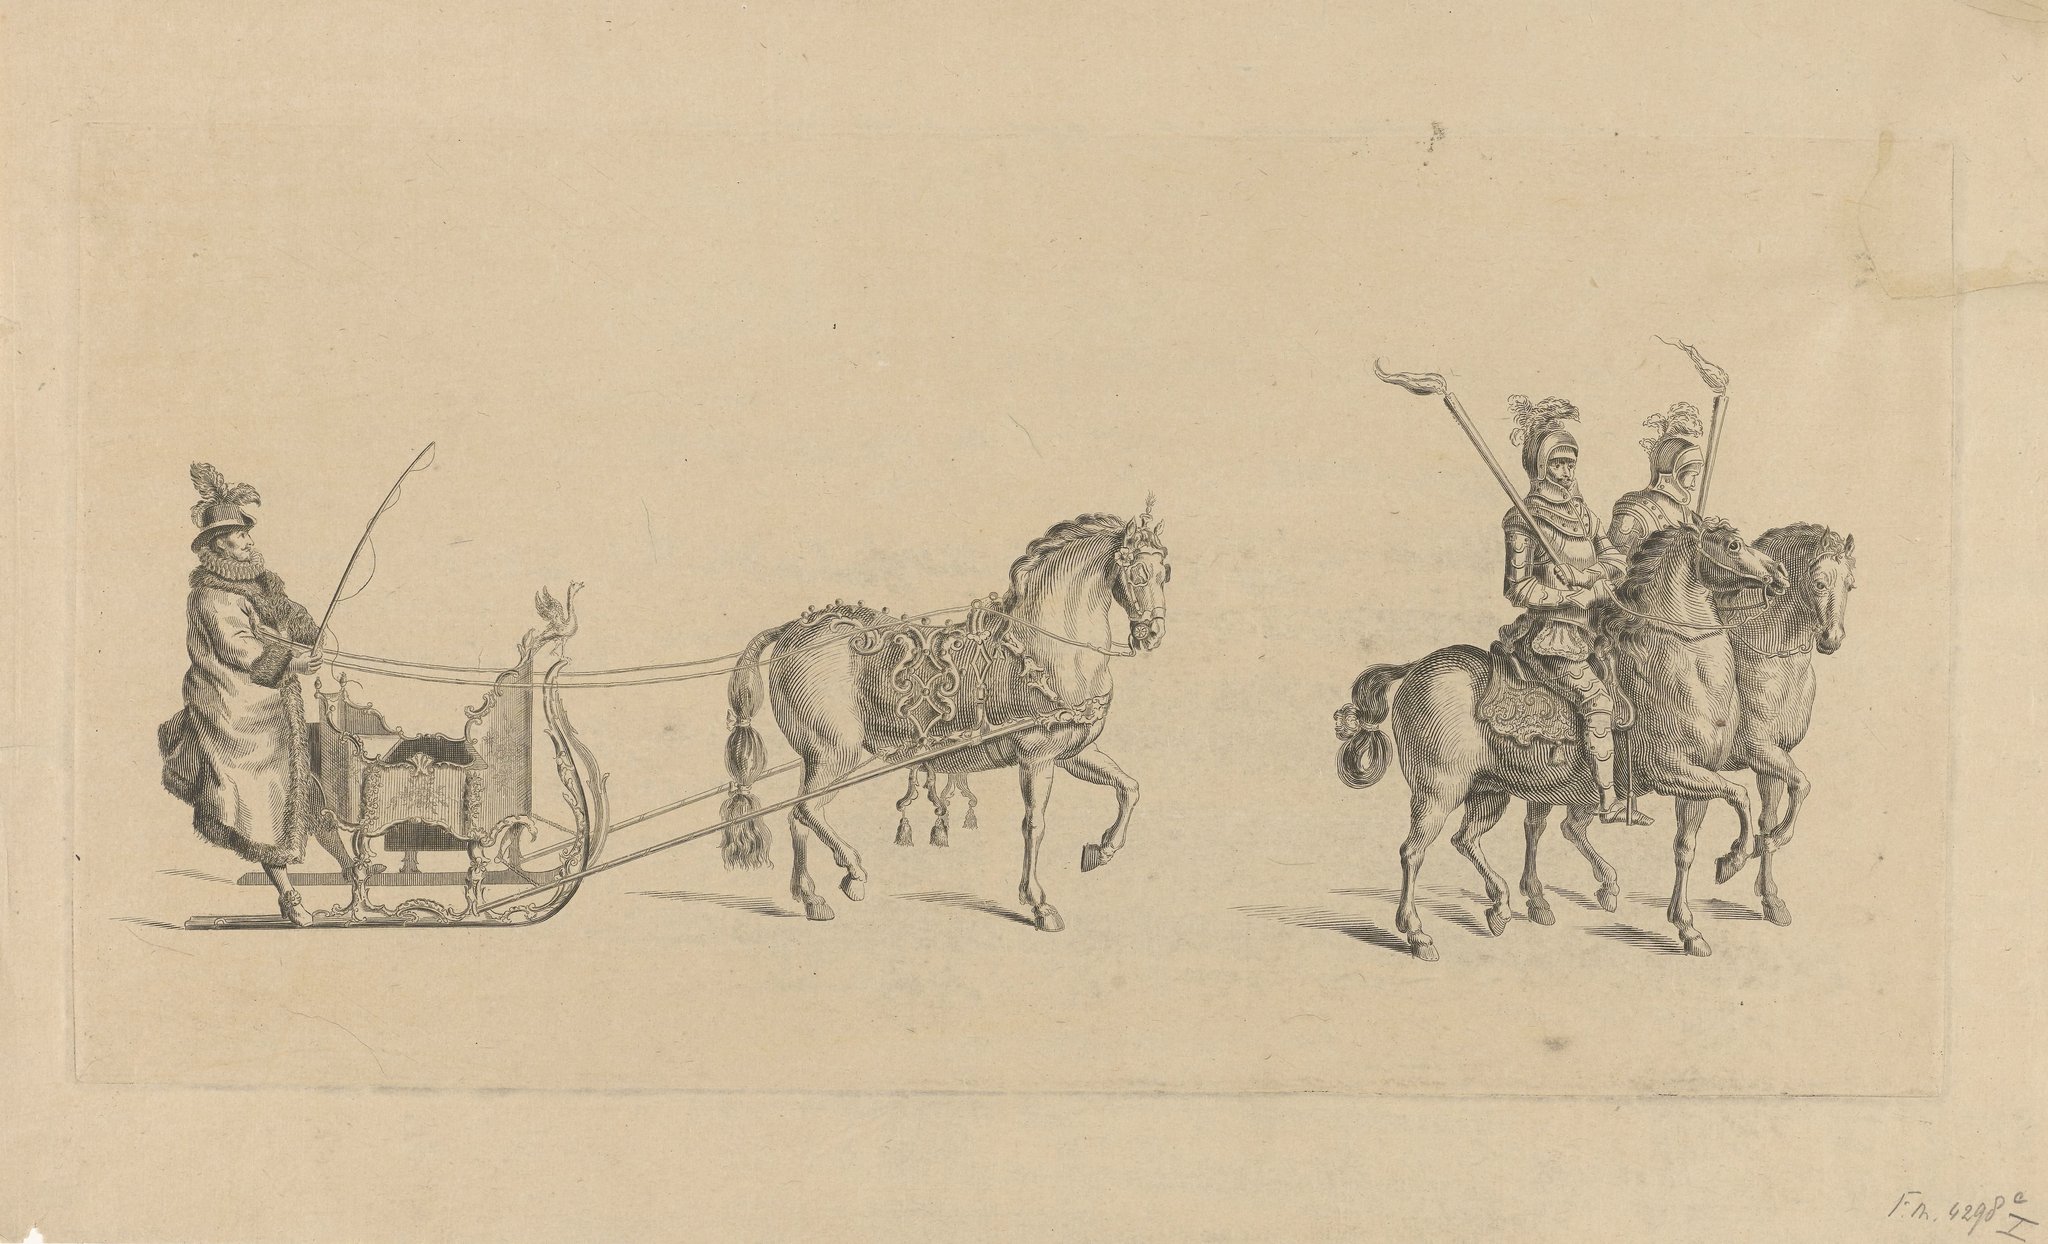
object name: print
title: Sledevaart van het Leidse genootschap Veniam Pro Laude in 1776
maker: nicolaas van der worm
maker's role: draughtsman, print maker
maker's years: 1757-1828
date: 1776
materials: paper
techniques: engraving, etching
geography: northern netherlands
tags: sledge, sleigh (winter sports), commemoration of the founding of a university, leiden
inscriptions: collector's mark: Lugt 240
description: De eerste slede in de optocht. Een Friese slede met een stalmeester voorafgegaan door twee ruiters in harnas met toortsen. Onderdeel van een reeks van twaalf platen (vóór het nummer en op ander papier) van de sledevaart op 24 januari 1776 georganiseerd door het Leidse genootschap Veniam Pro Laude bij gelegenheid van het Tweede Eeuwfeest van het Leids Ontzet (3 oktober 1574) en de oprichting van de Universiteit van Leiden (8 februari 1575).